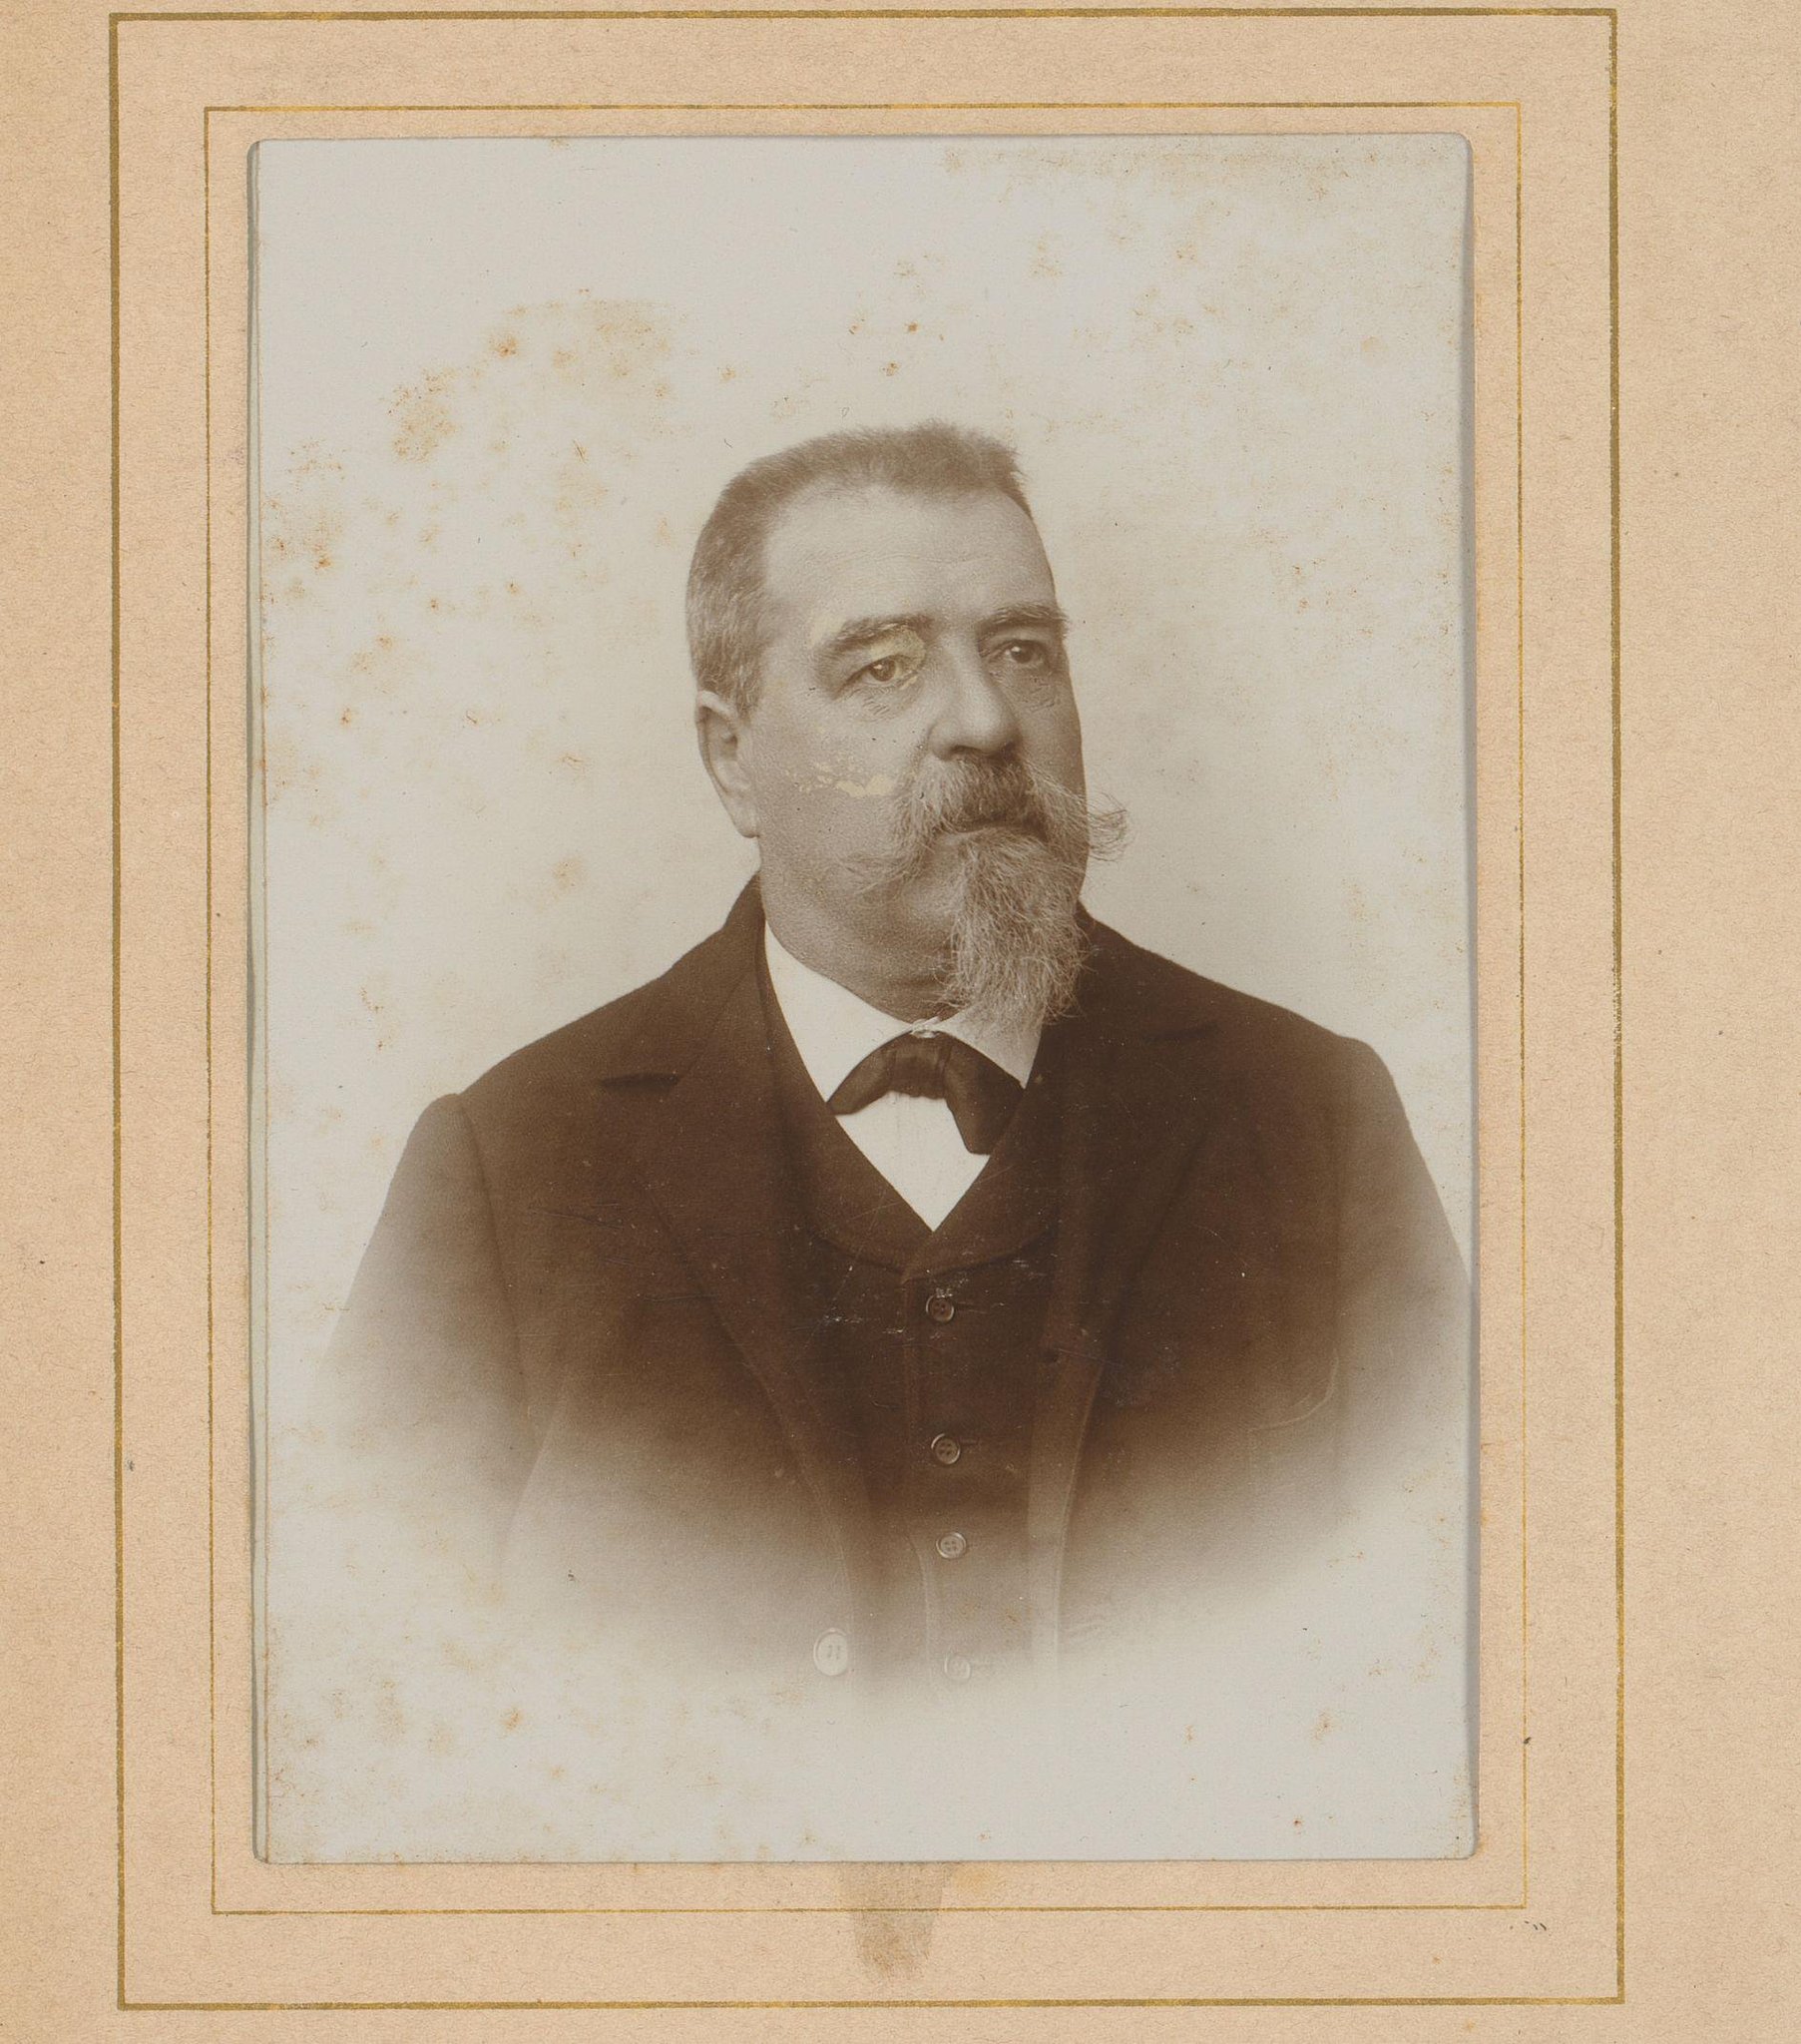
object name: album leaf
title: Portret van een man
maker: jacques prévot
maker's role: fotograaf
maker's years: 1857-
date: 1870-1900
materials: cardboard, photographic support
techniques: collodion silver print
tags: adult man, historical persons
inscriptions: name: ‘6, Rue de l'Offrande J. Prévot/Anvers’, inscription: ‘Photographie/ J. Prévot/ 6, Rue de l'Offrande/ coin de la rue Dambrugge/ Anvers’